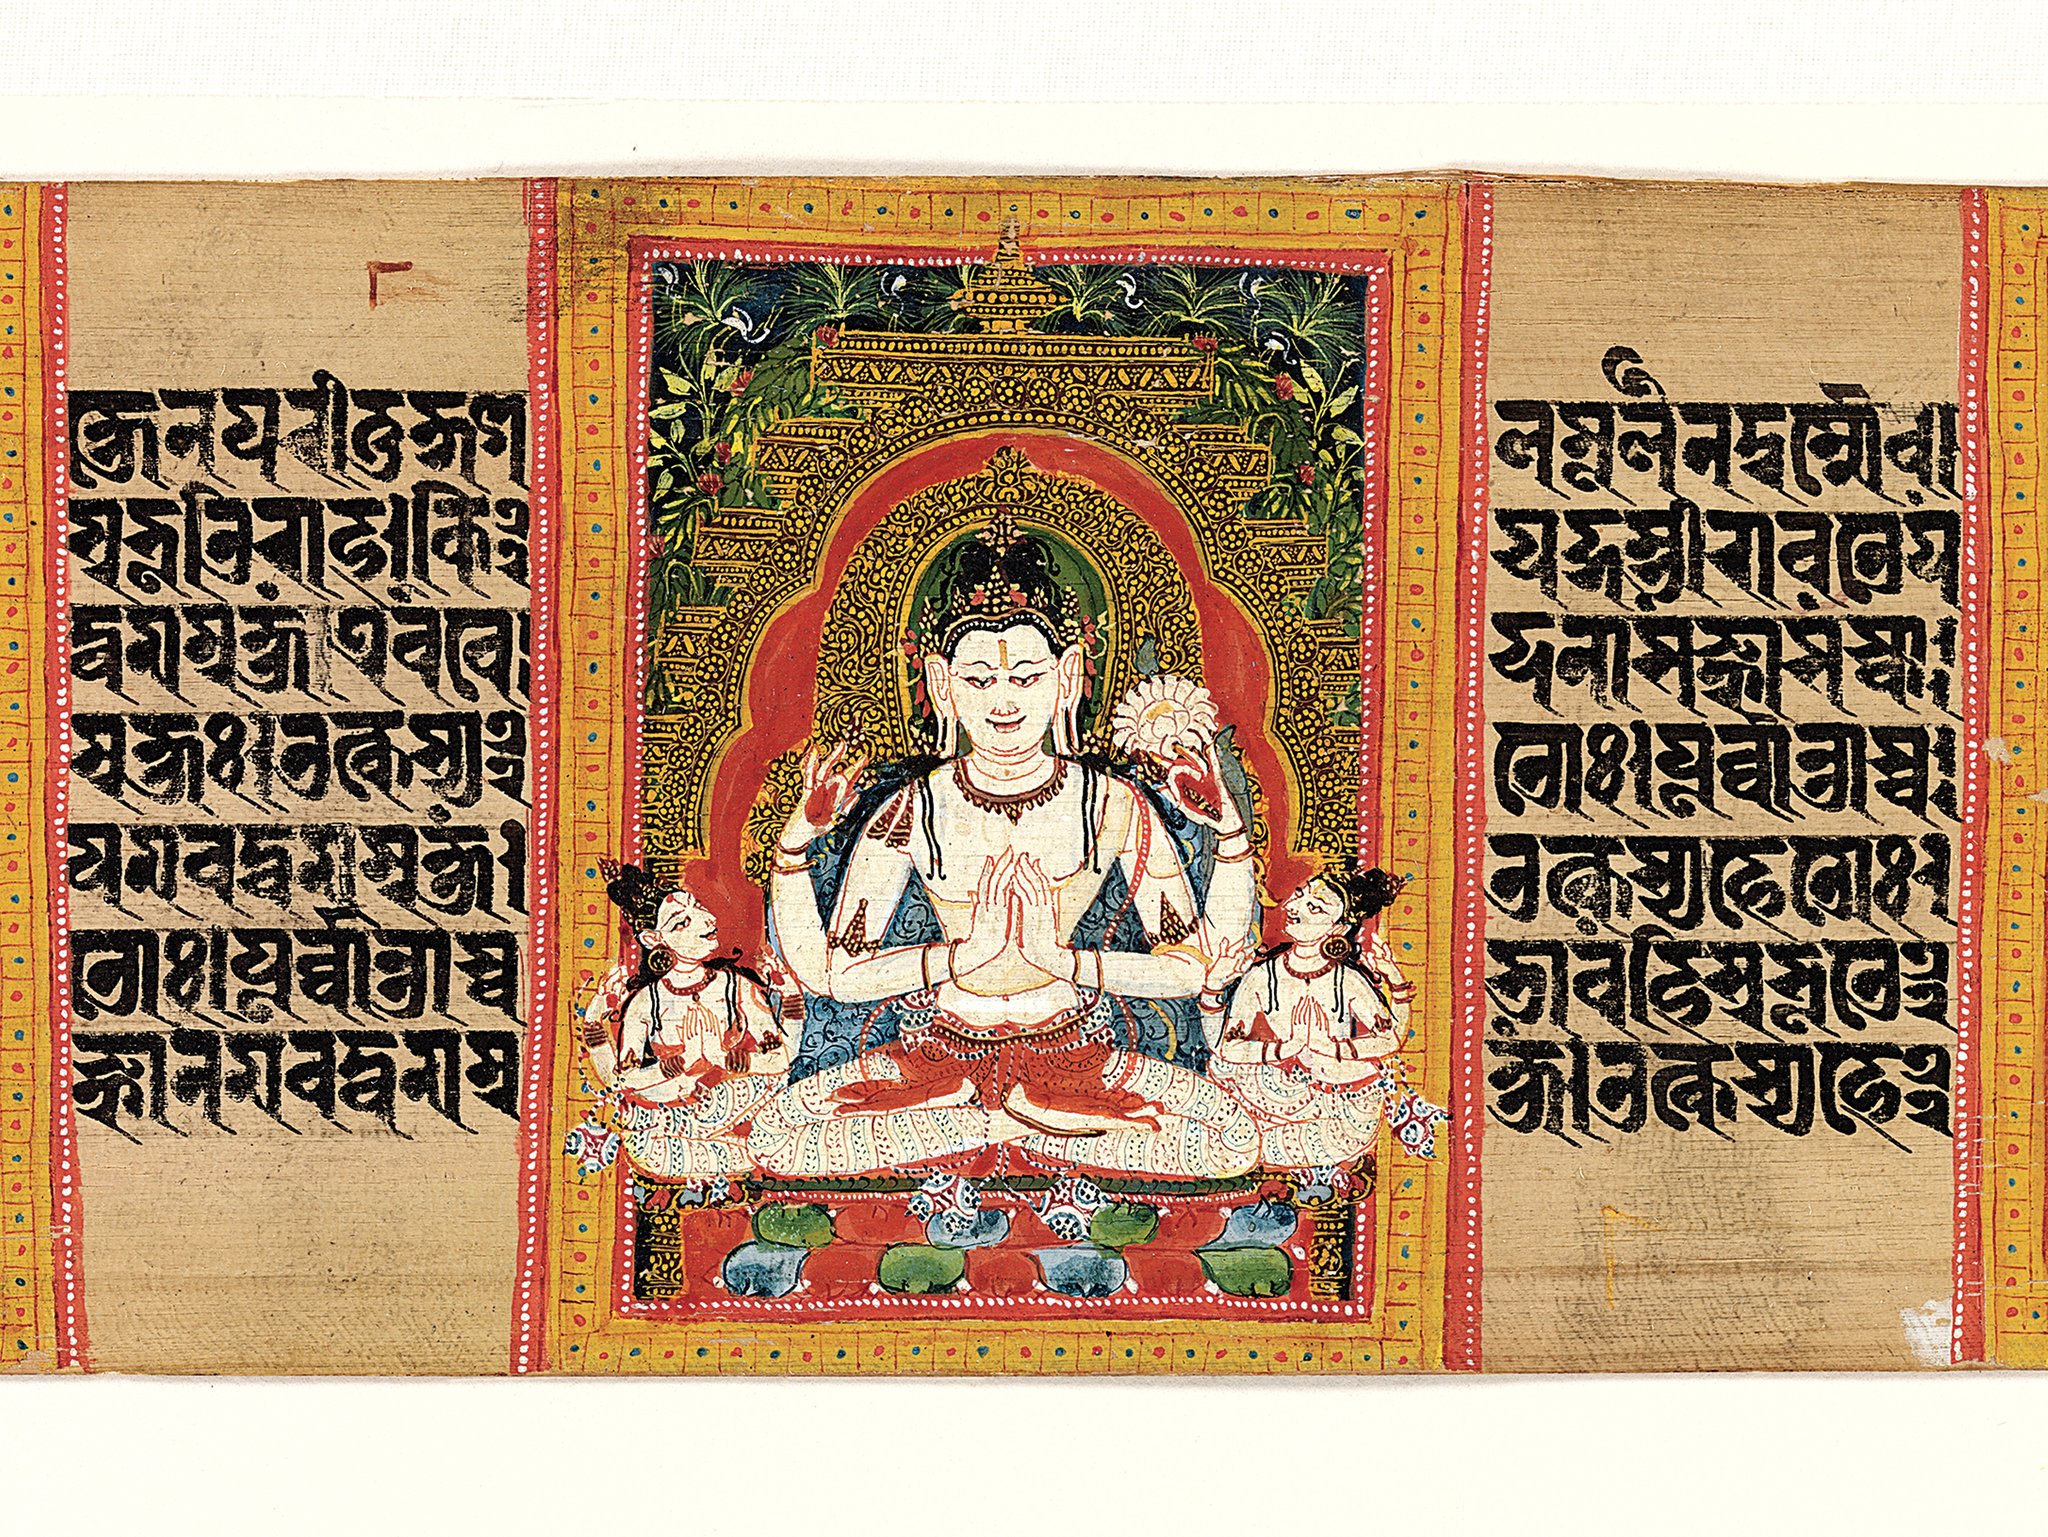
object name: folio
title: Leaves from an Ashtasahasrika Prajnaparamita Sutra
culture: indian or west bengali or bangladeshi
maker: mahavihara master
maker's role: artist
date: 1101-1133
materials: ink, leaf, pigment, watercolor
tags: bodhisattvas